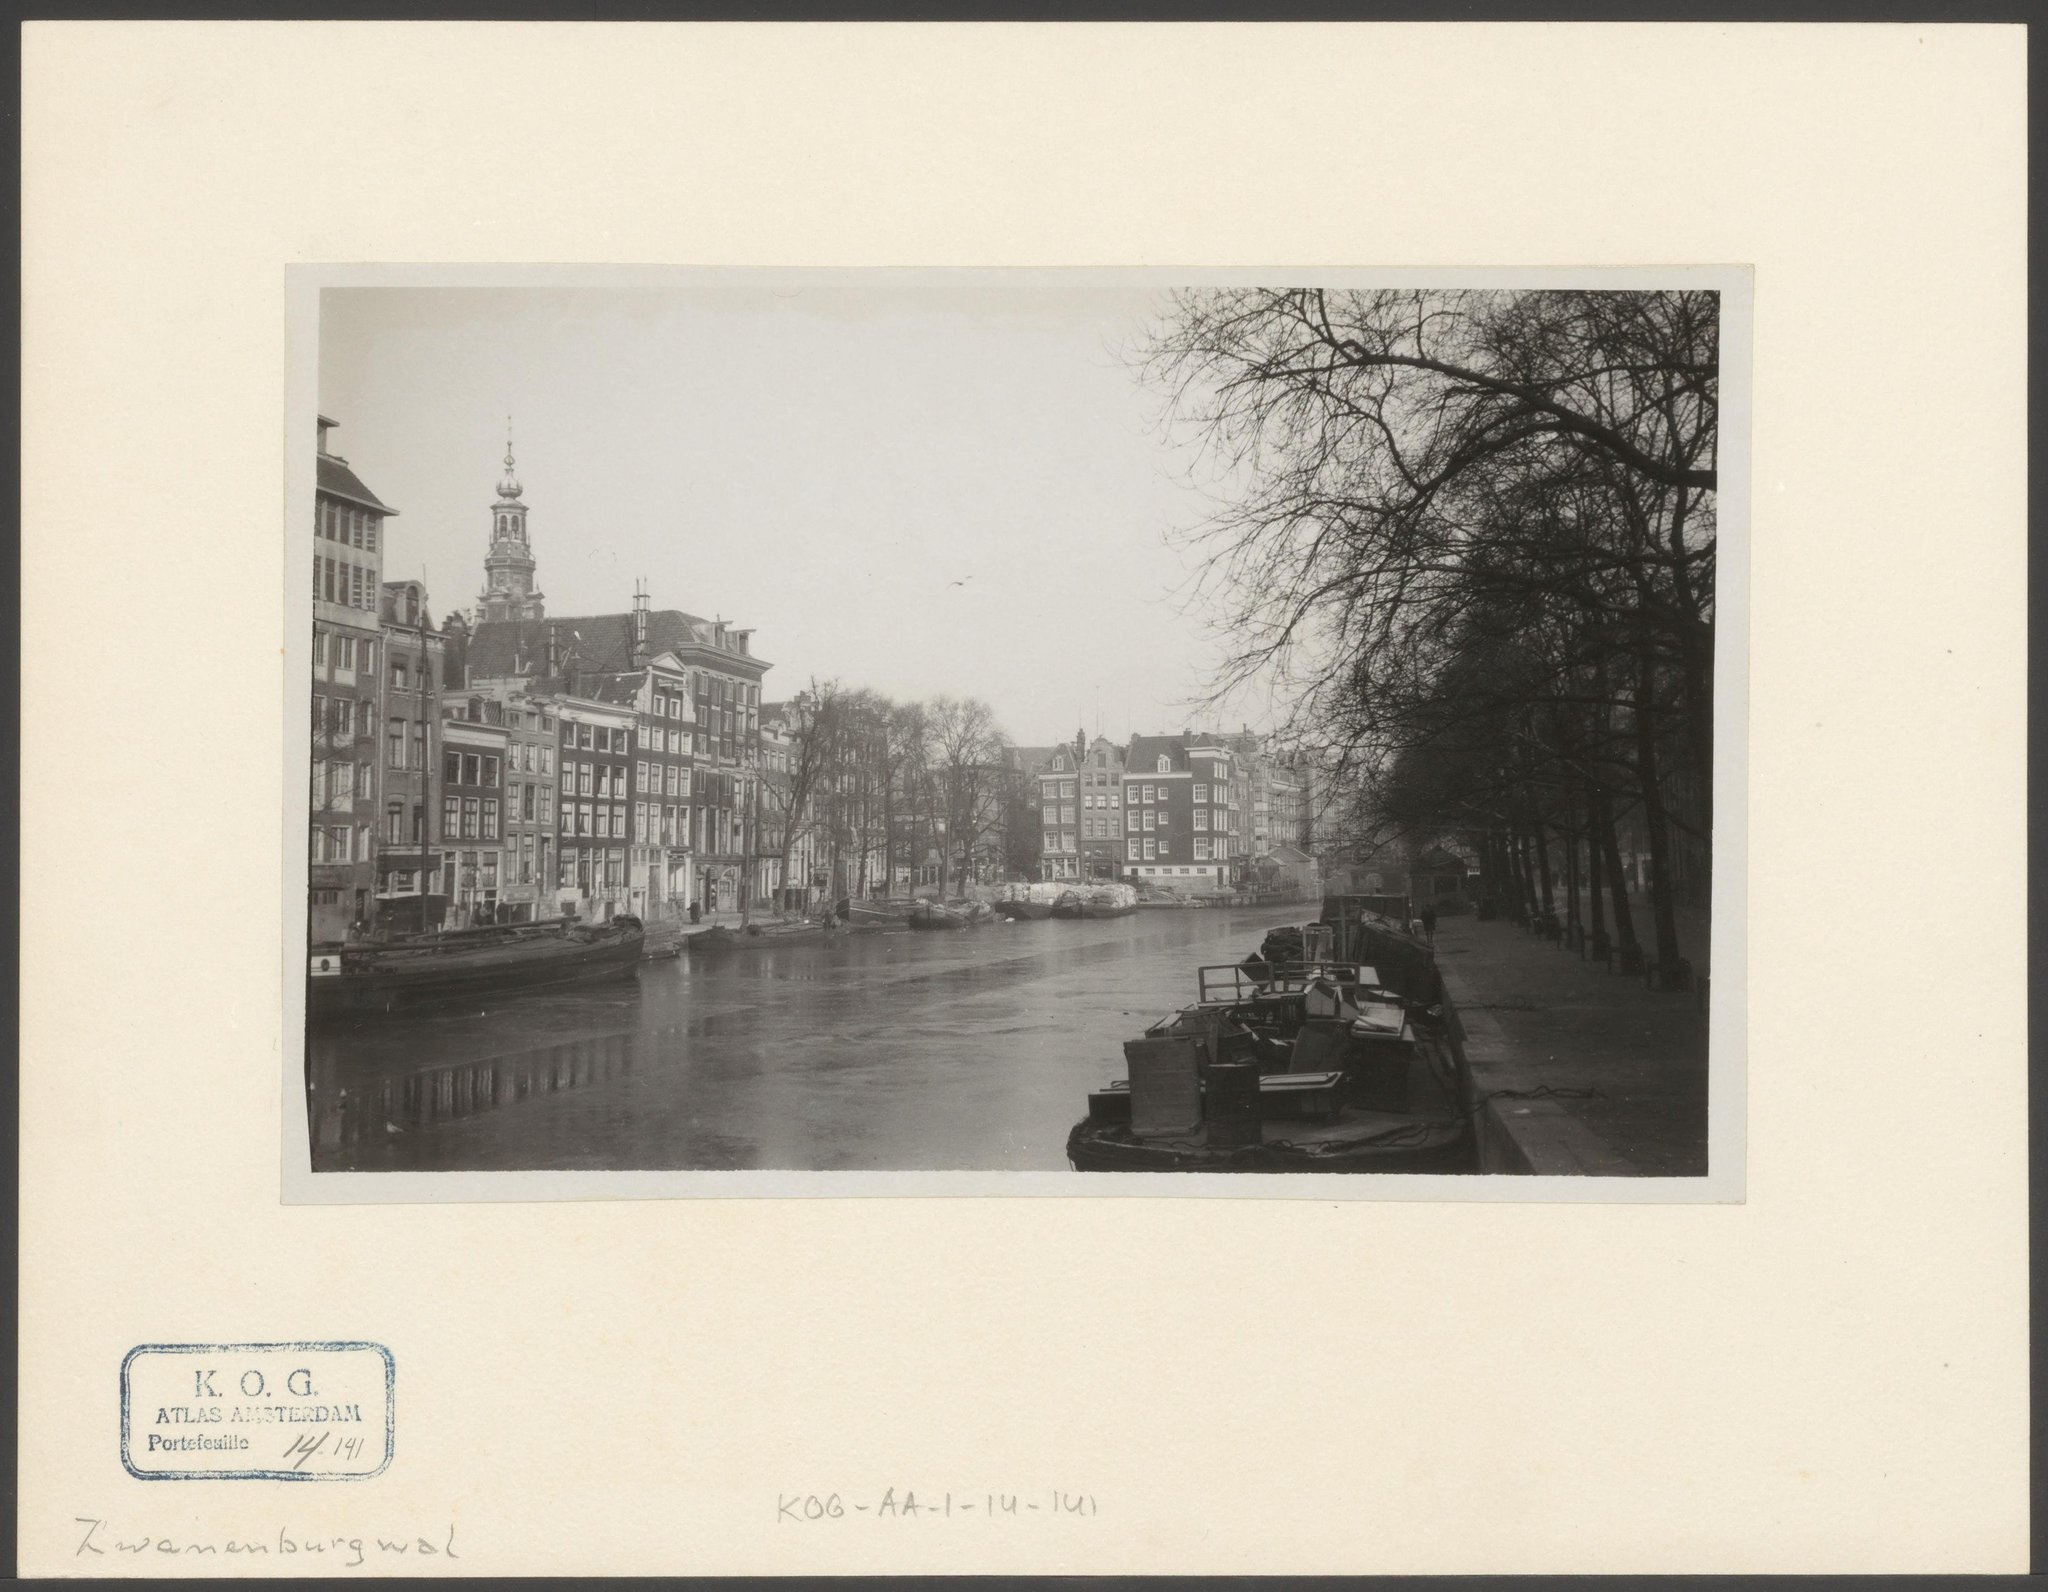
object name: photograph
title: Gezicht op de Zwanenburgwal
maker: Anonymous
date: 1880-1950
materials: paper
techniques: gelatin silver print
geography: amsterdam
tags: tower, clock tower ~ monumental adornment, city-view in general; 'veduta', canal, street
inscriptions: inscription: ‘Zwanenburgwal’, collector's mark: ‘14.141’ Lugt 1641b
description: Onderwerpsrubriek binnen de Atlas Amsterdam: Zaagmolensloot, Zandpad, Zeeburg, Zeeburgerdijk, Zeeburgerpad, Zeeburgerstraat, Zwanenburgwal, Zwartebijlsteeg.